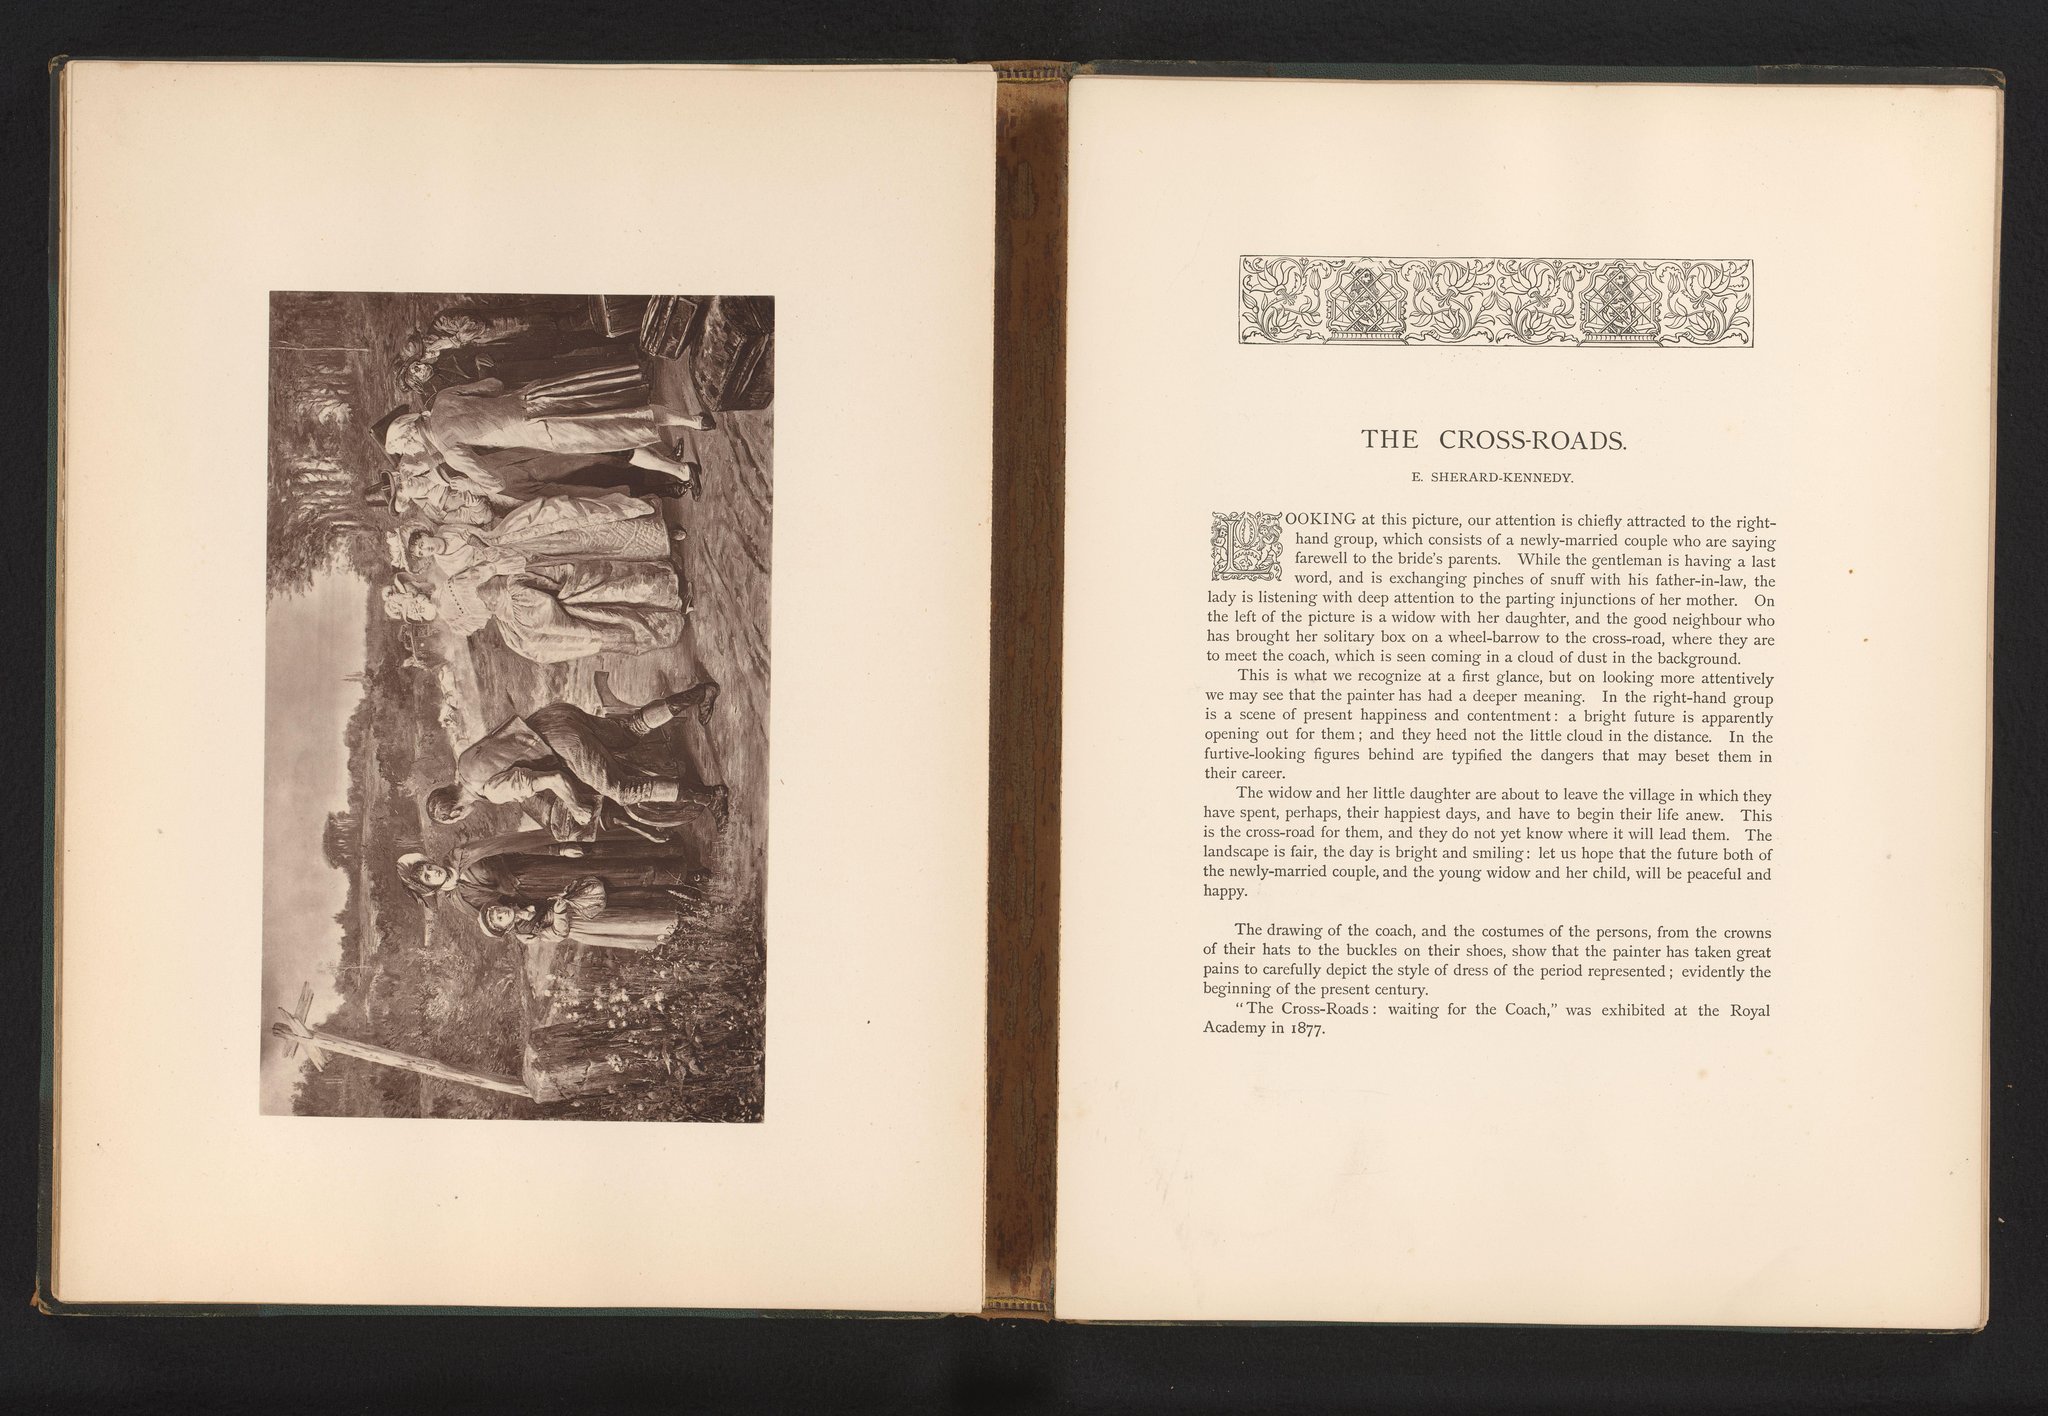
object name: reproduction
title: Reproductie van een schilderij van een reisgezelschap op een splitsing door Edward Sherrard Kennedy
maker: Anonymous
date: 1874-1879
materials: paper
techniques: woodburytype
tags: cross-roads, bifurcation, asking the way